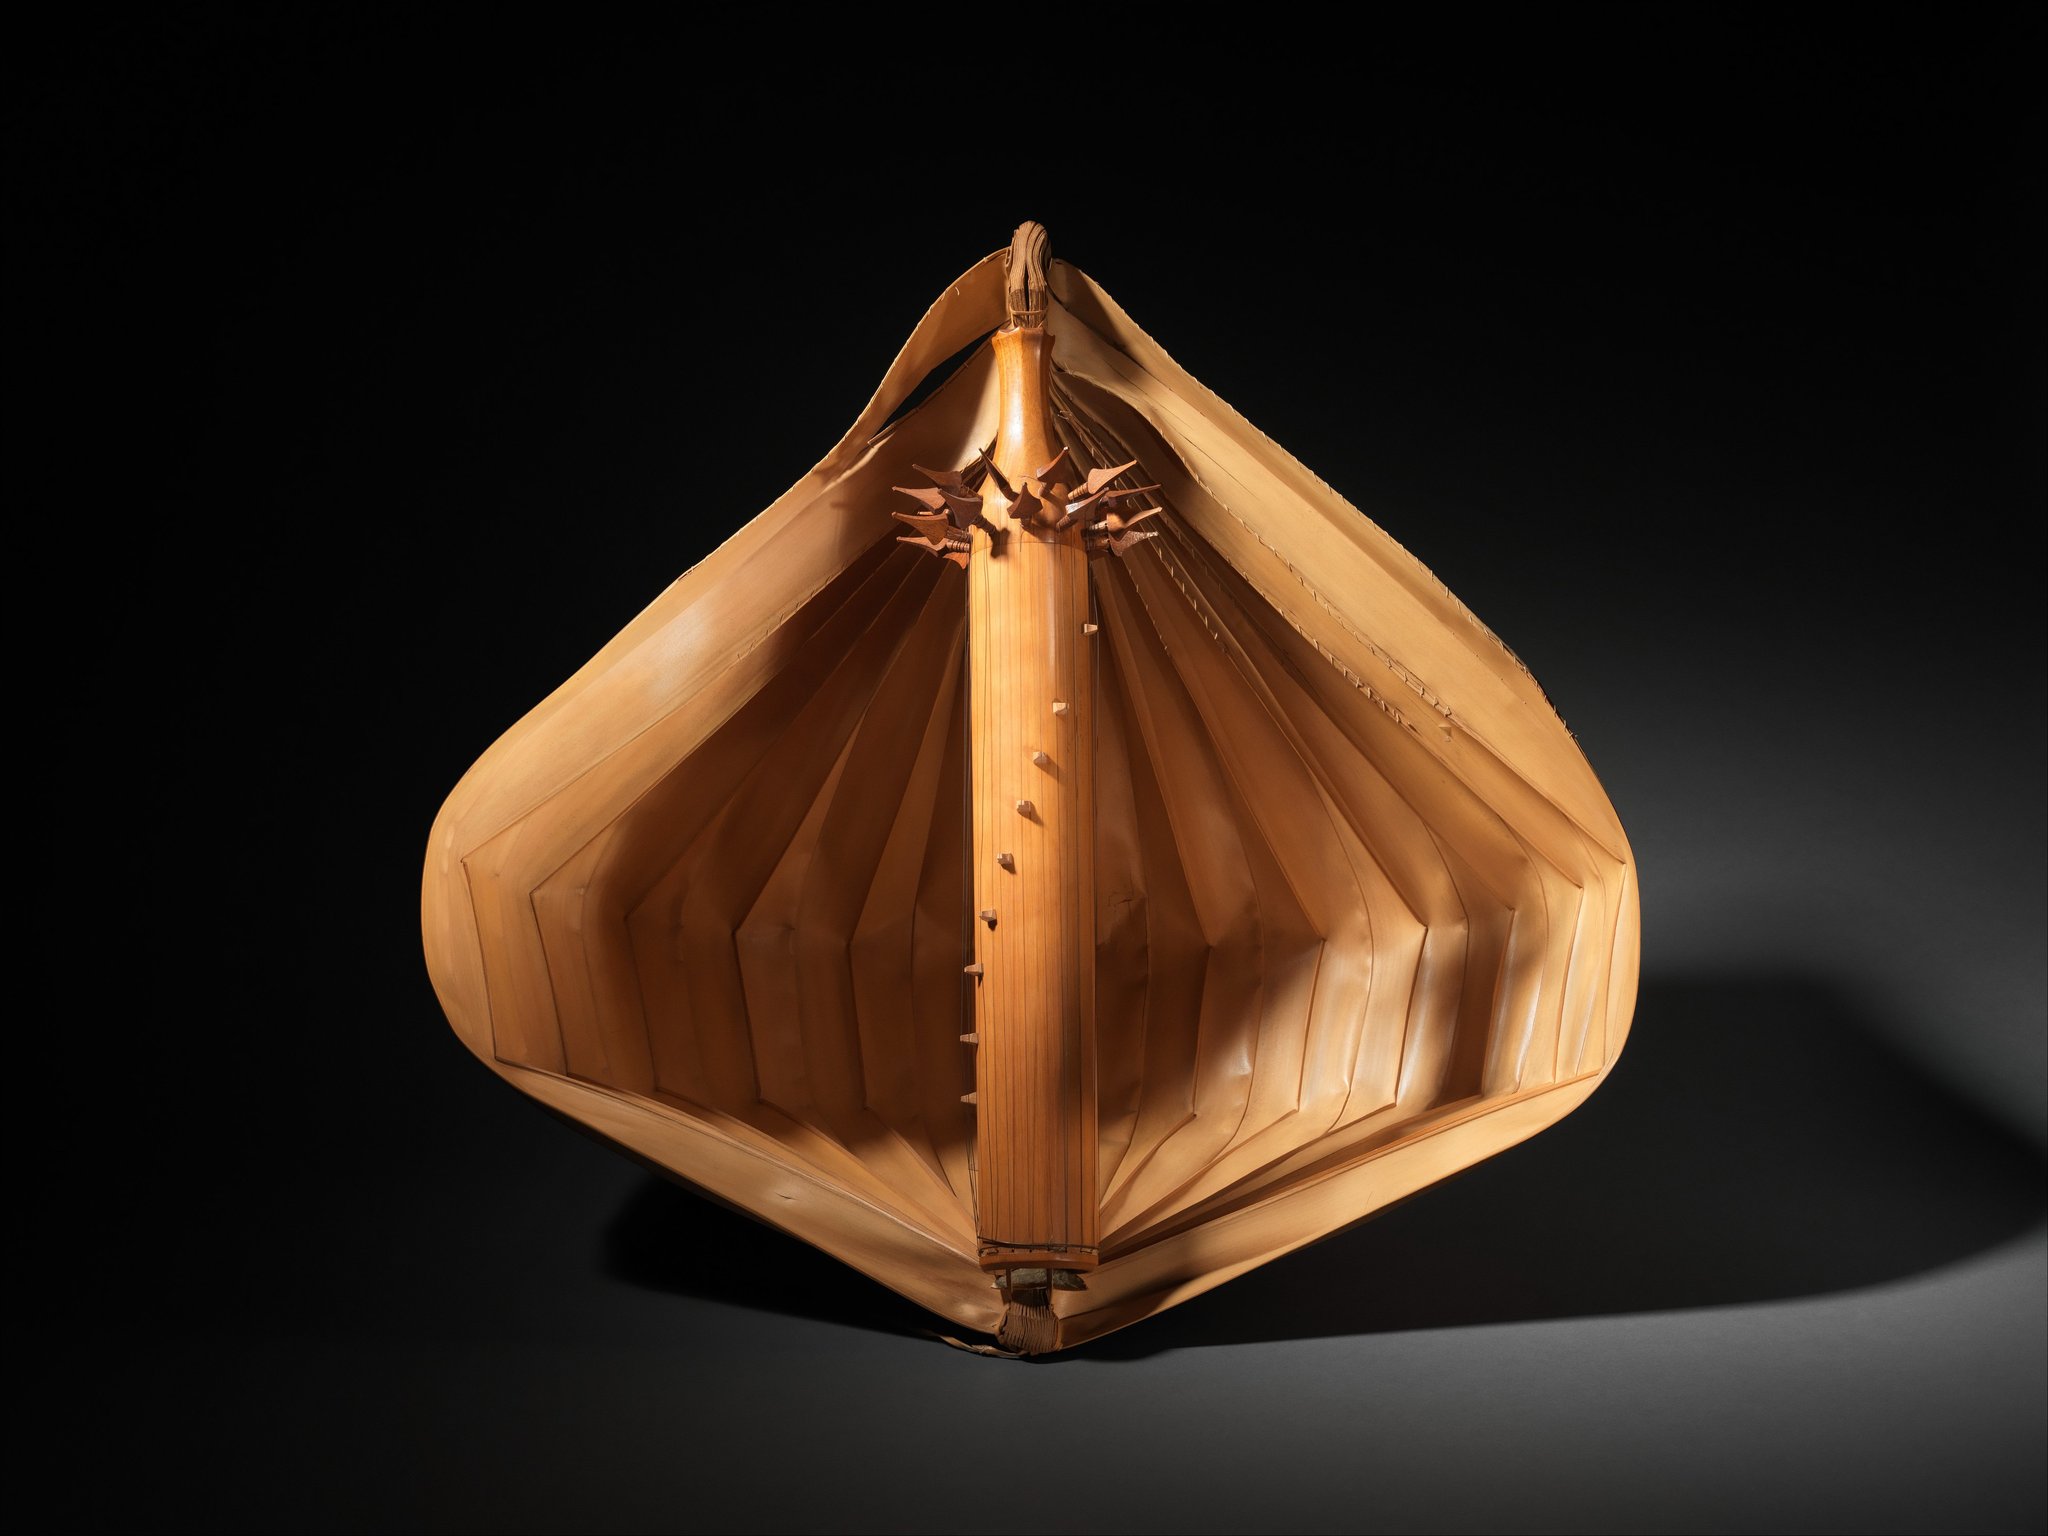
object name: sesando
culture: javanese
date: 1867-1900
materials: bamboo, metal, wood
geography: indonesia